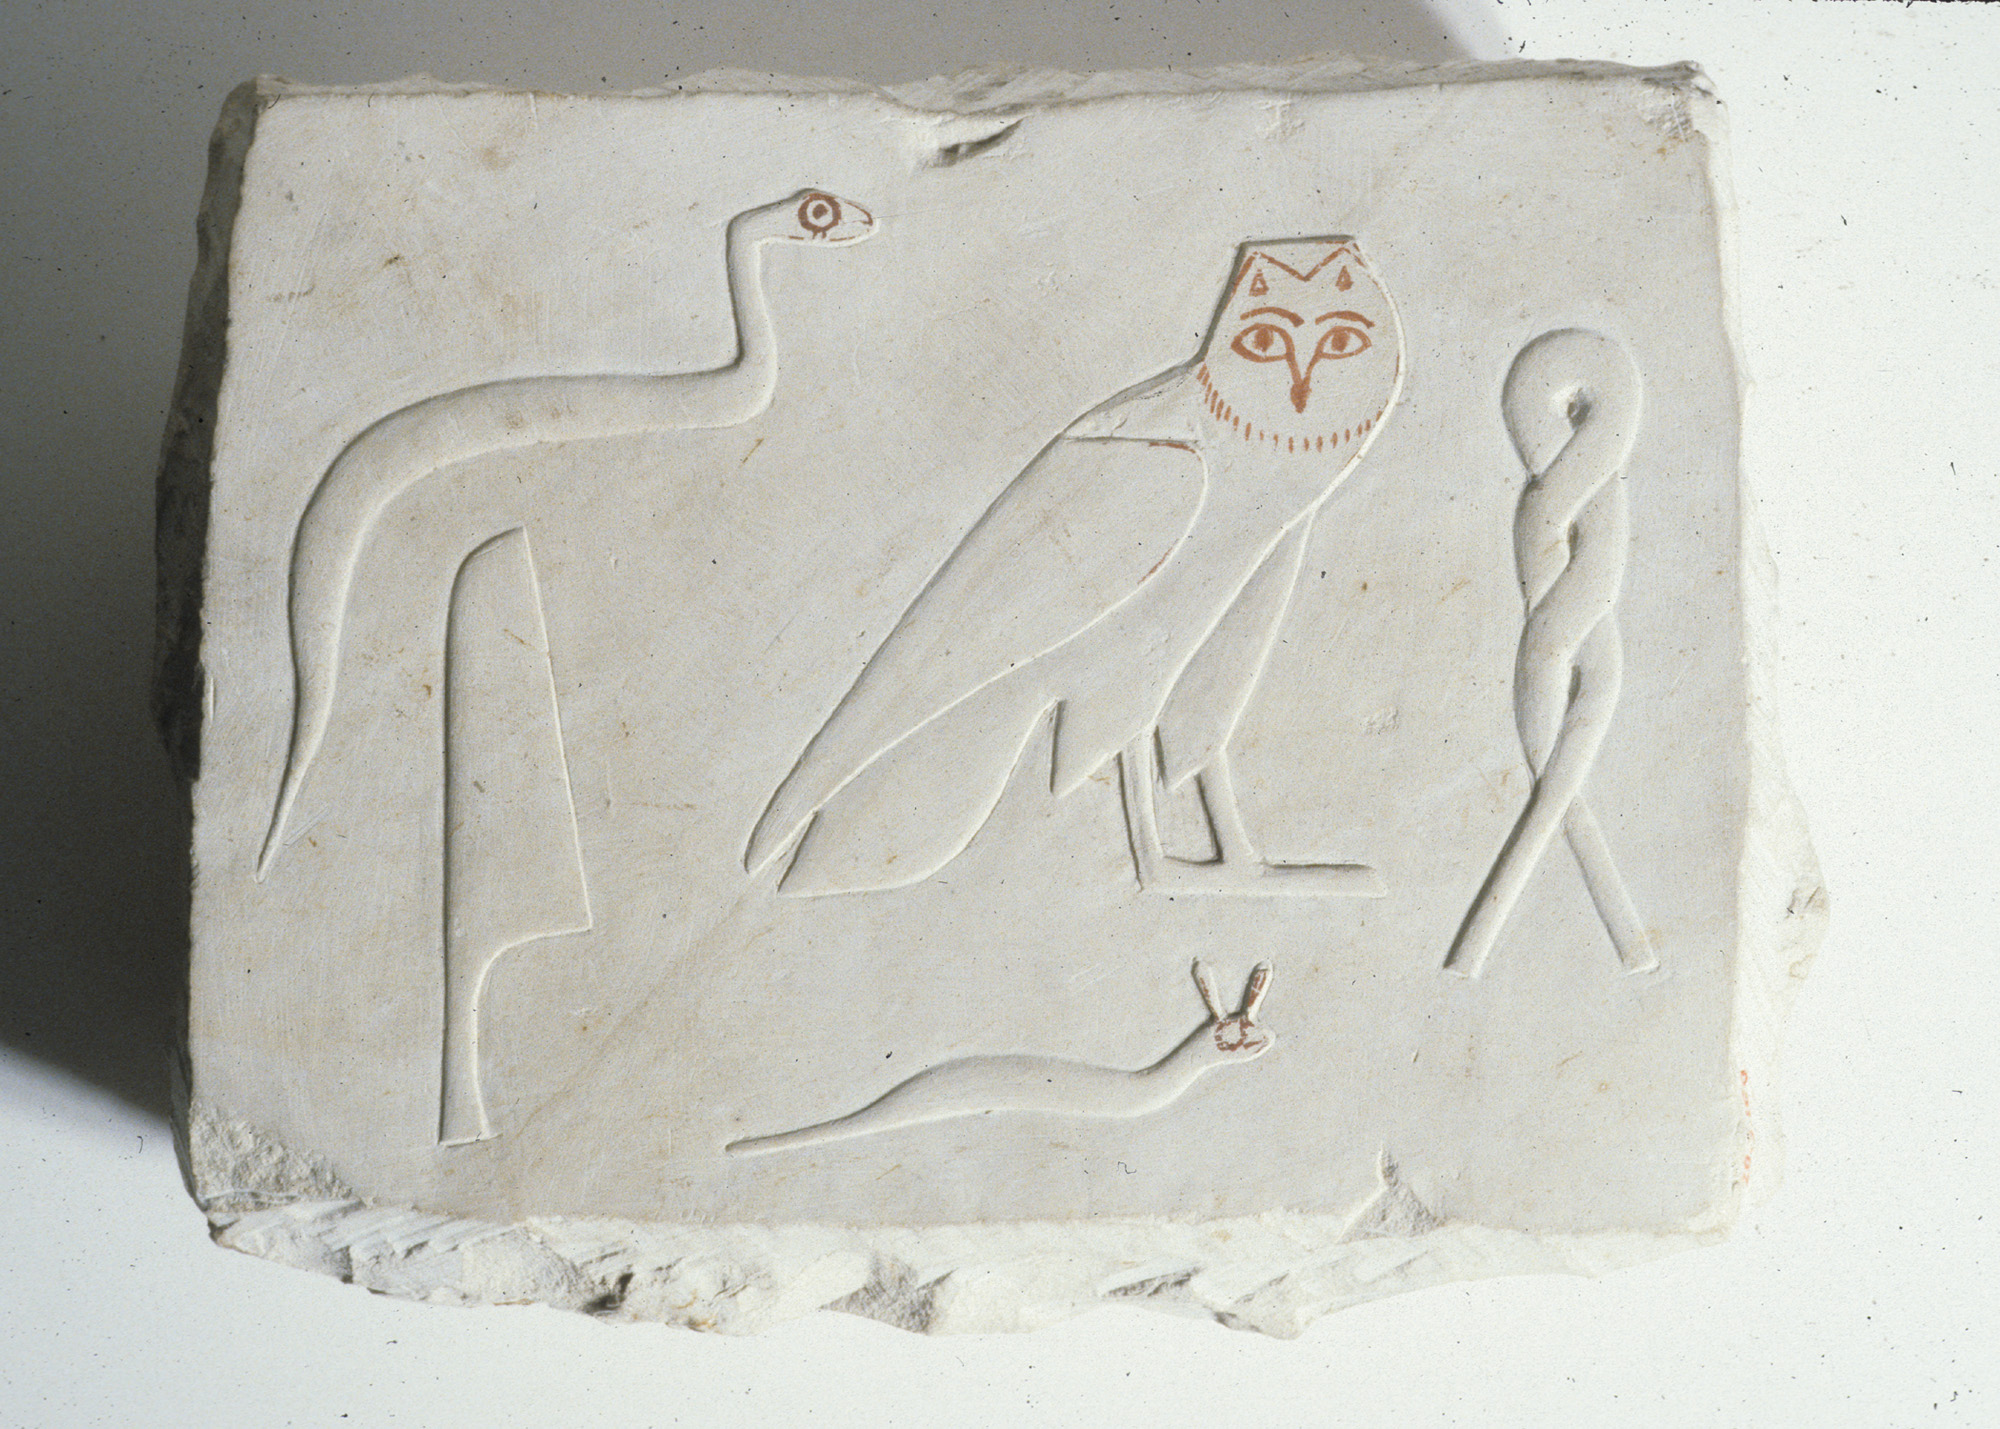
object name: hieroglyph, inscription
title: Unfinished hieroglyphs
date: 1981-1975 BCE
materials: ink, limestone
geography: egypt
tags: hieroglyphs,owls,snakes